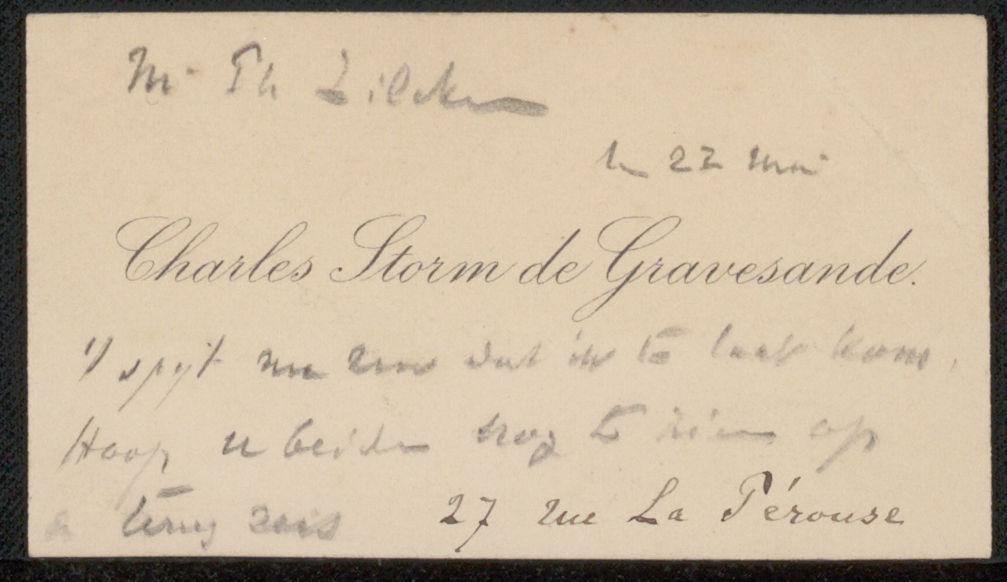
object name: visiting card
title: Visitekaartje aan Philip Zilcken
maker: carel nicolaas storm van s-gravesande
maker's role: draughtsman, print maker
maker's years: 1841-1924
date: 1851-1924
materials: cardboard, ink, pencil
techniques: pen, printing, writing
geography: paris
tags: the hague, painter, draughtsman, philip zilcken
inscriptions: collector's mark: ‘RPK’